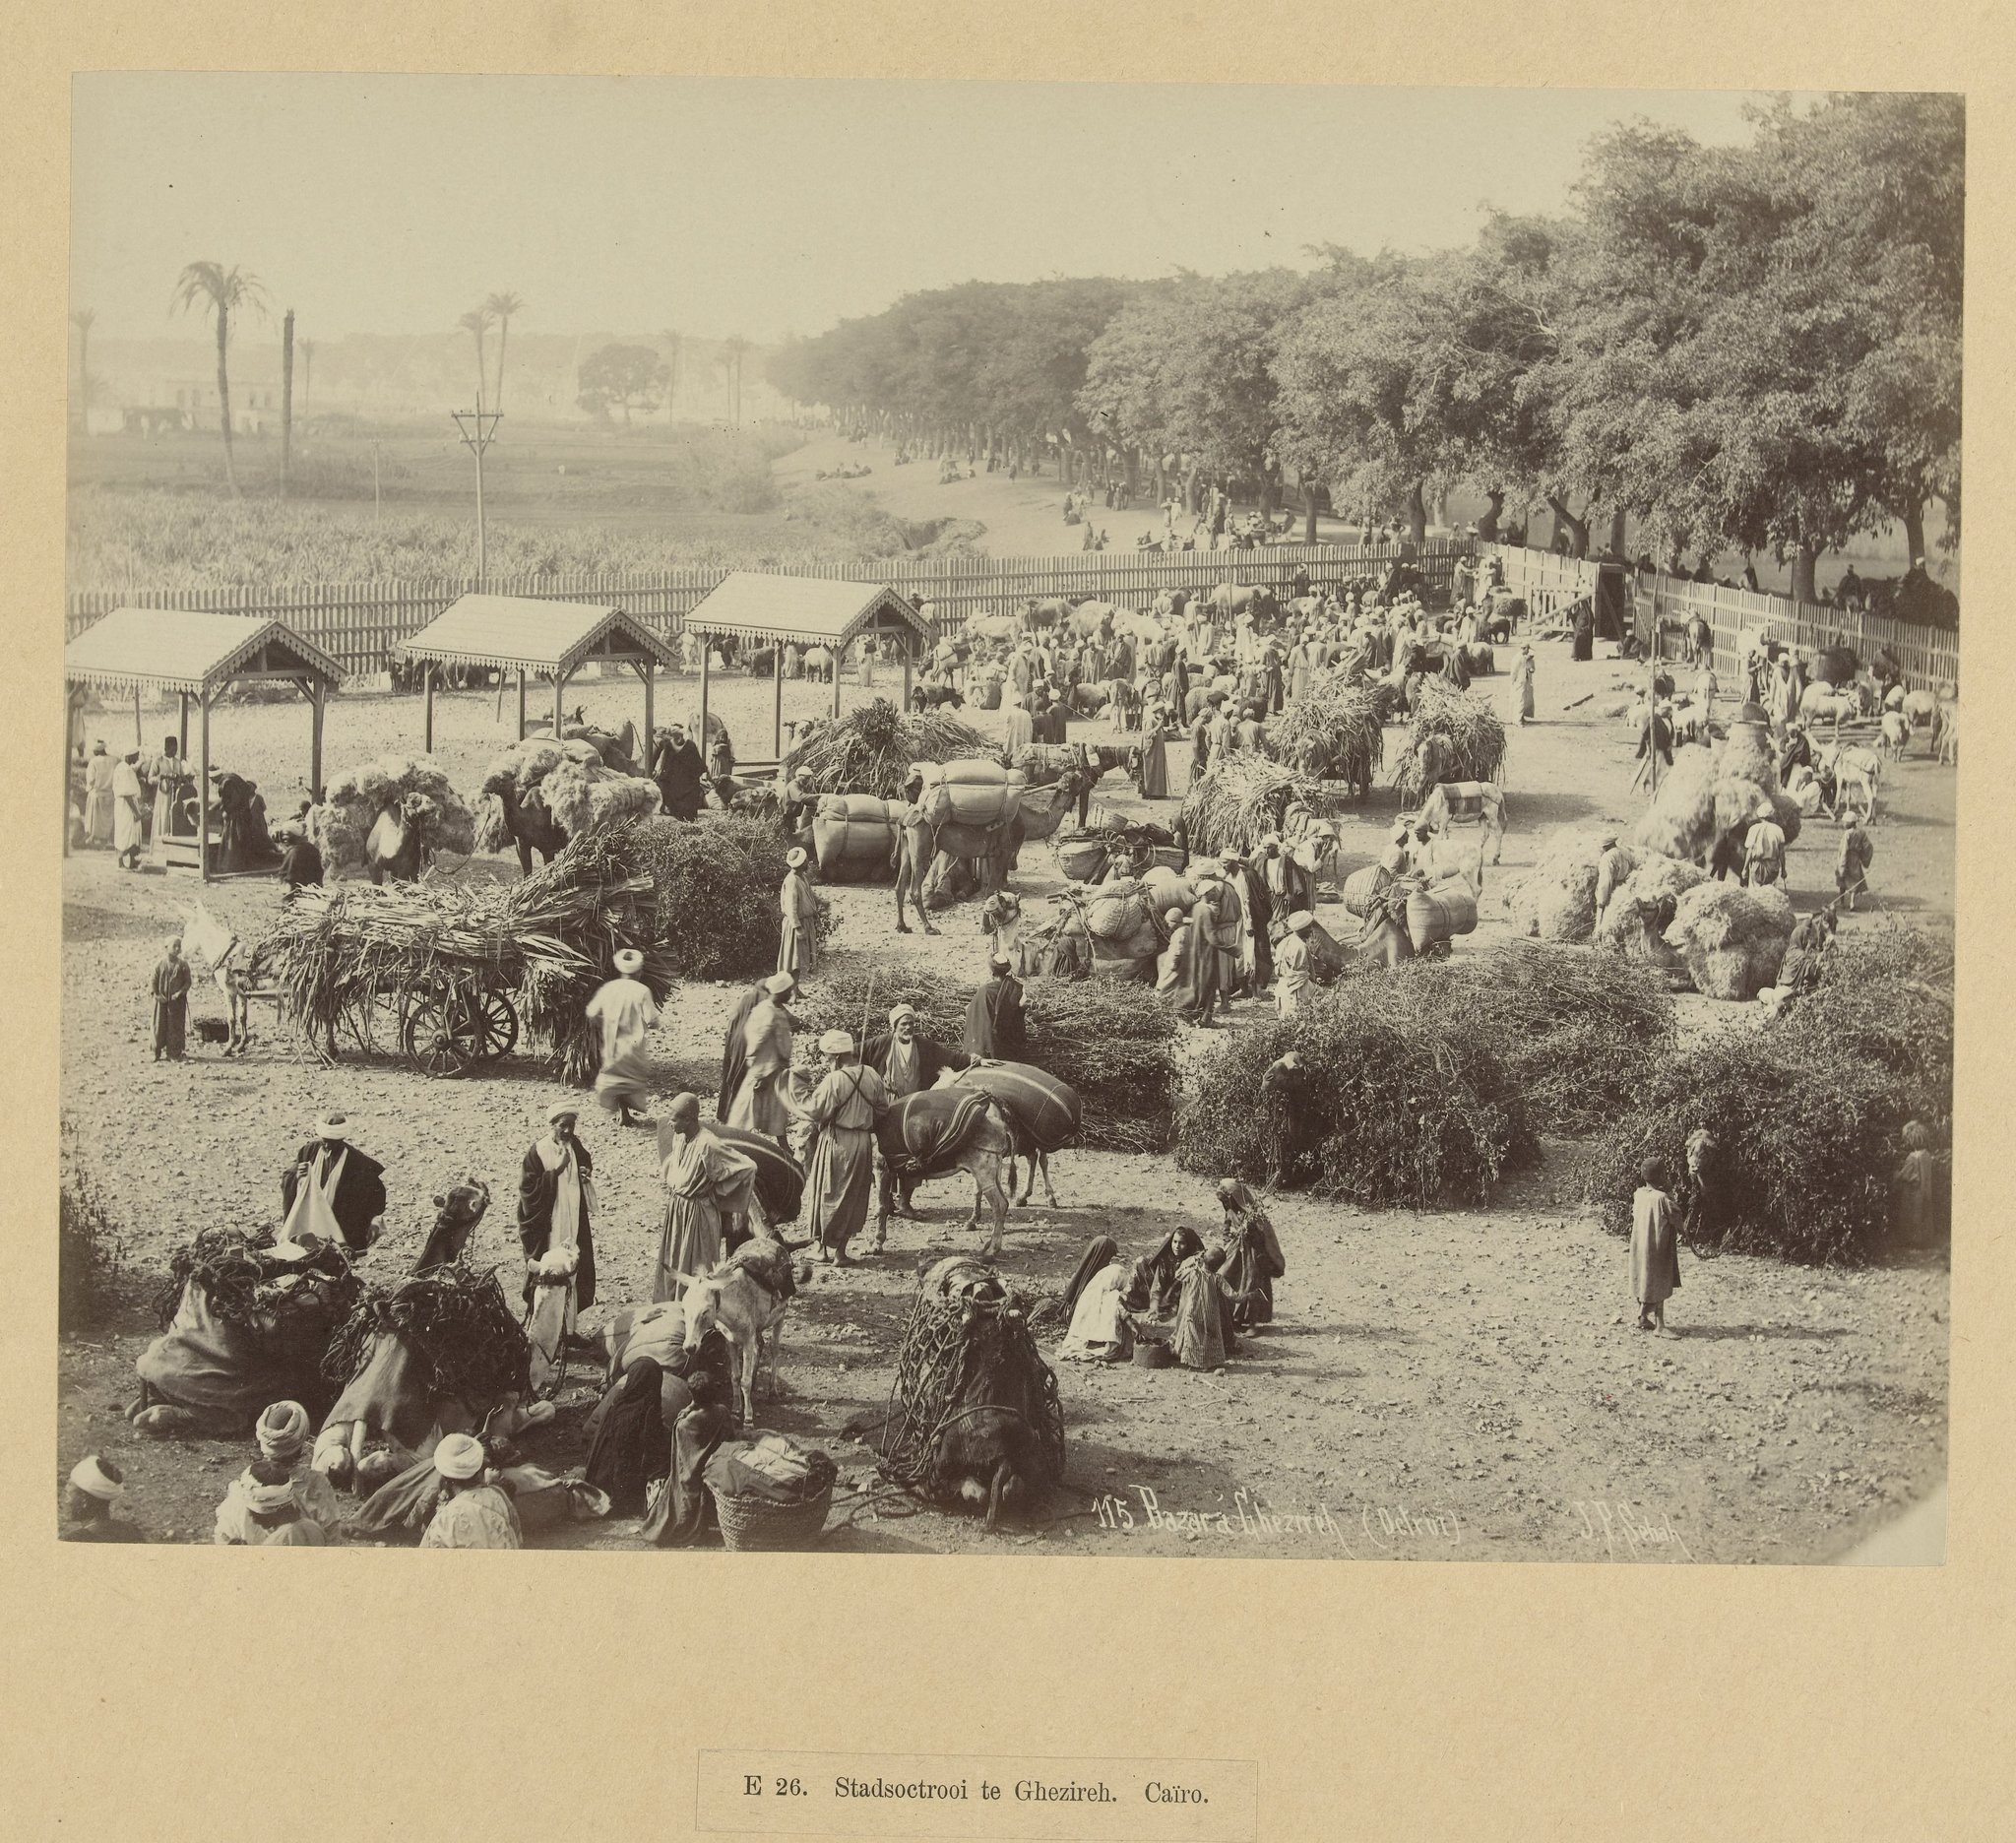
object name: photograph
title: E 26. Stadsoctrooi te Ghezireh. Caïro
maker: jean pascal sébah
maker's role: fotograaf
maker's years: 1872-1947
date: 1888-1895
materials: cardboard, paper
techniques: albumen print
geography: cairo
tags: market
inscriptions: title: ‘E 26. Stadsoctrooi te Ghezireh. Caïro.’, stamp: ‘Gemeentelijke bibliotheek/ Rotterdam’, check stamp: ‘Bristol/ L.M.’, number: ‘115’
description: Onderdeel van een groep door fotograaf Richard Polak op reis verzamelde foto’s. Deze foto is samen met andere op zijn reizen verzamelde foto's tentoongesteld bij de Rotterdamsche Kunstkring (1895), Arti en Amicitiae te Amsterdam (1897-1898?) en Societeit 't Collegie te Kampen (datum vooralsnog onbekend).